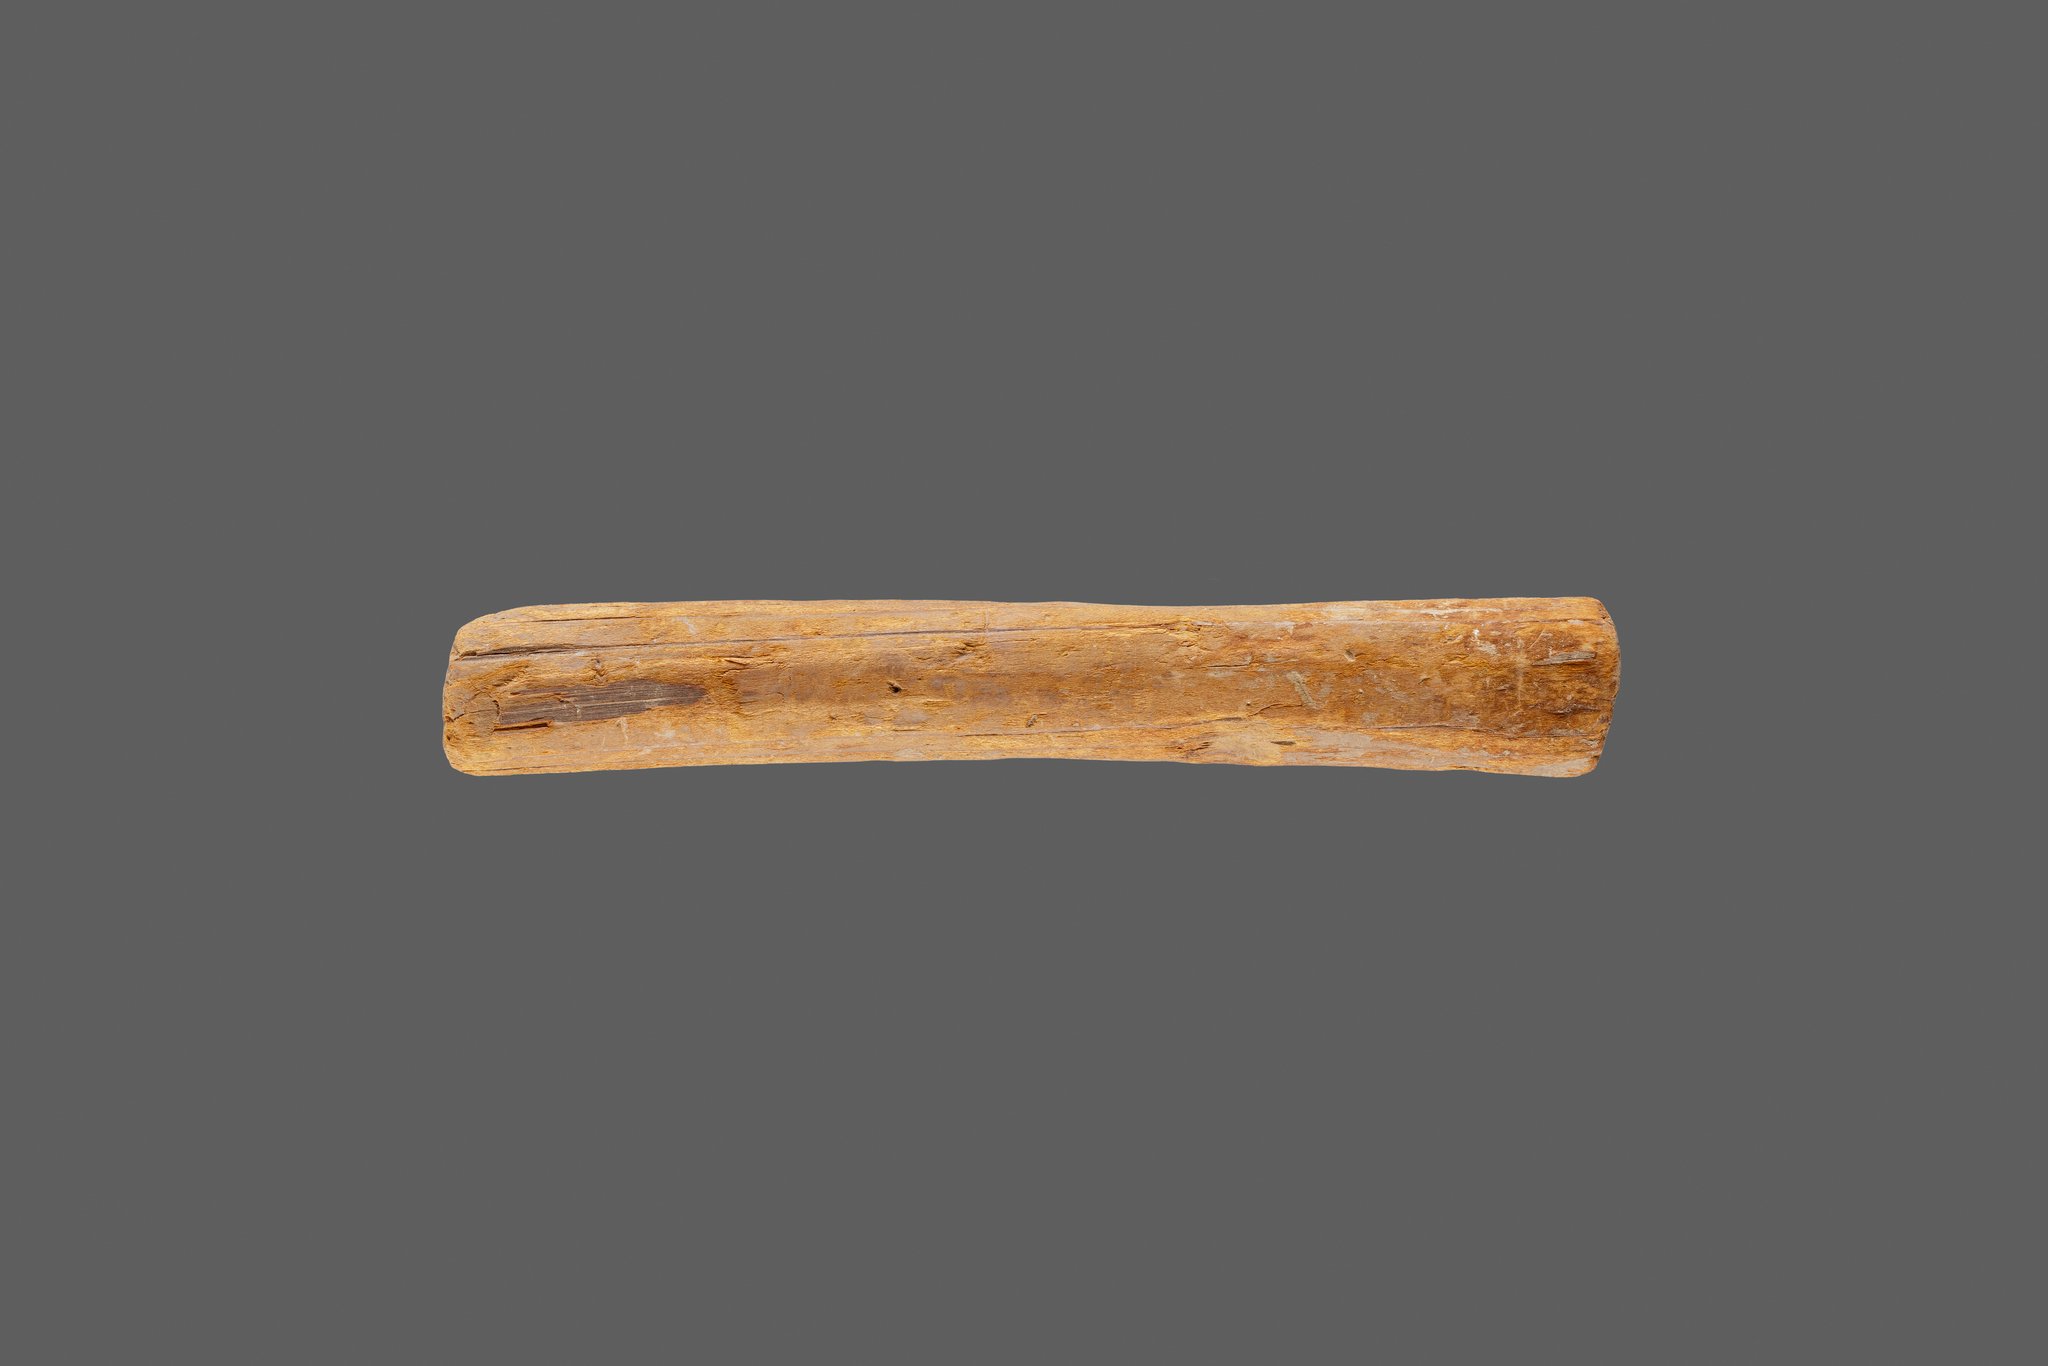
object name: coffin rope handle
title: Handle for rope for lowering coffin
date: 1070-945 BCE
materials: wood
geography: egypt